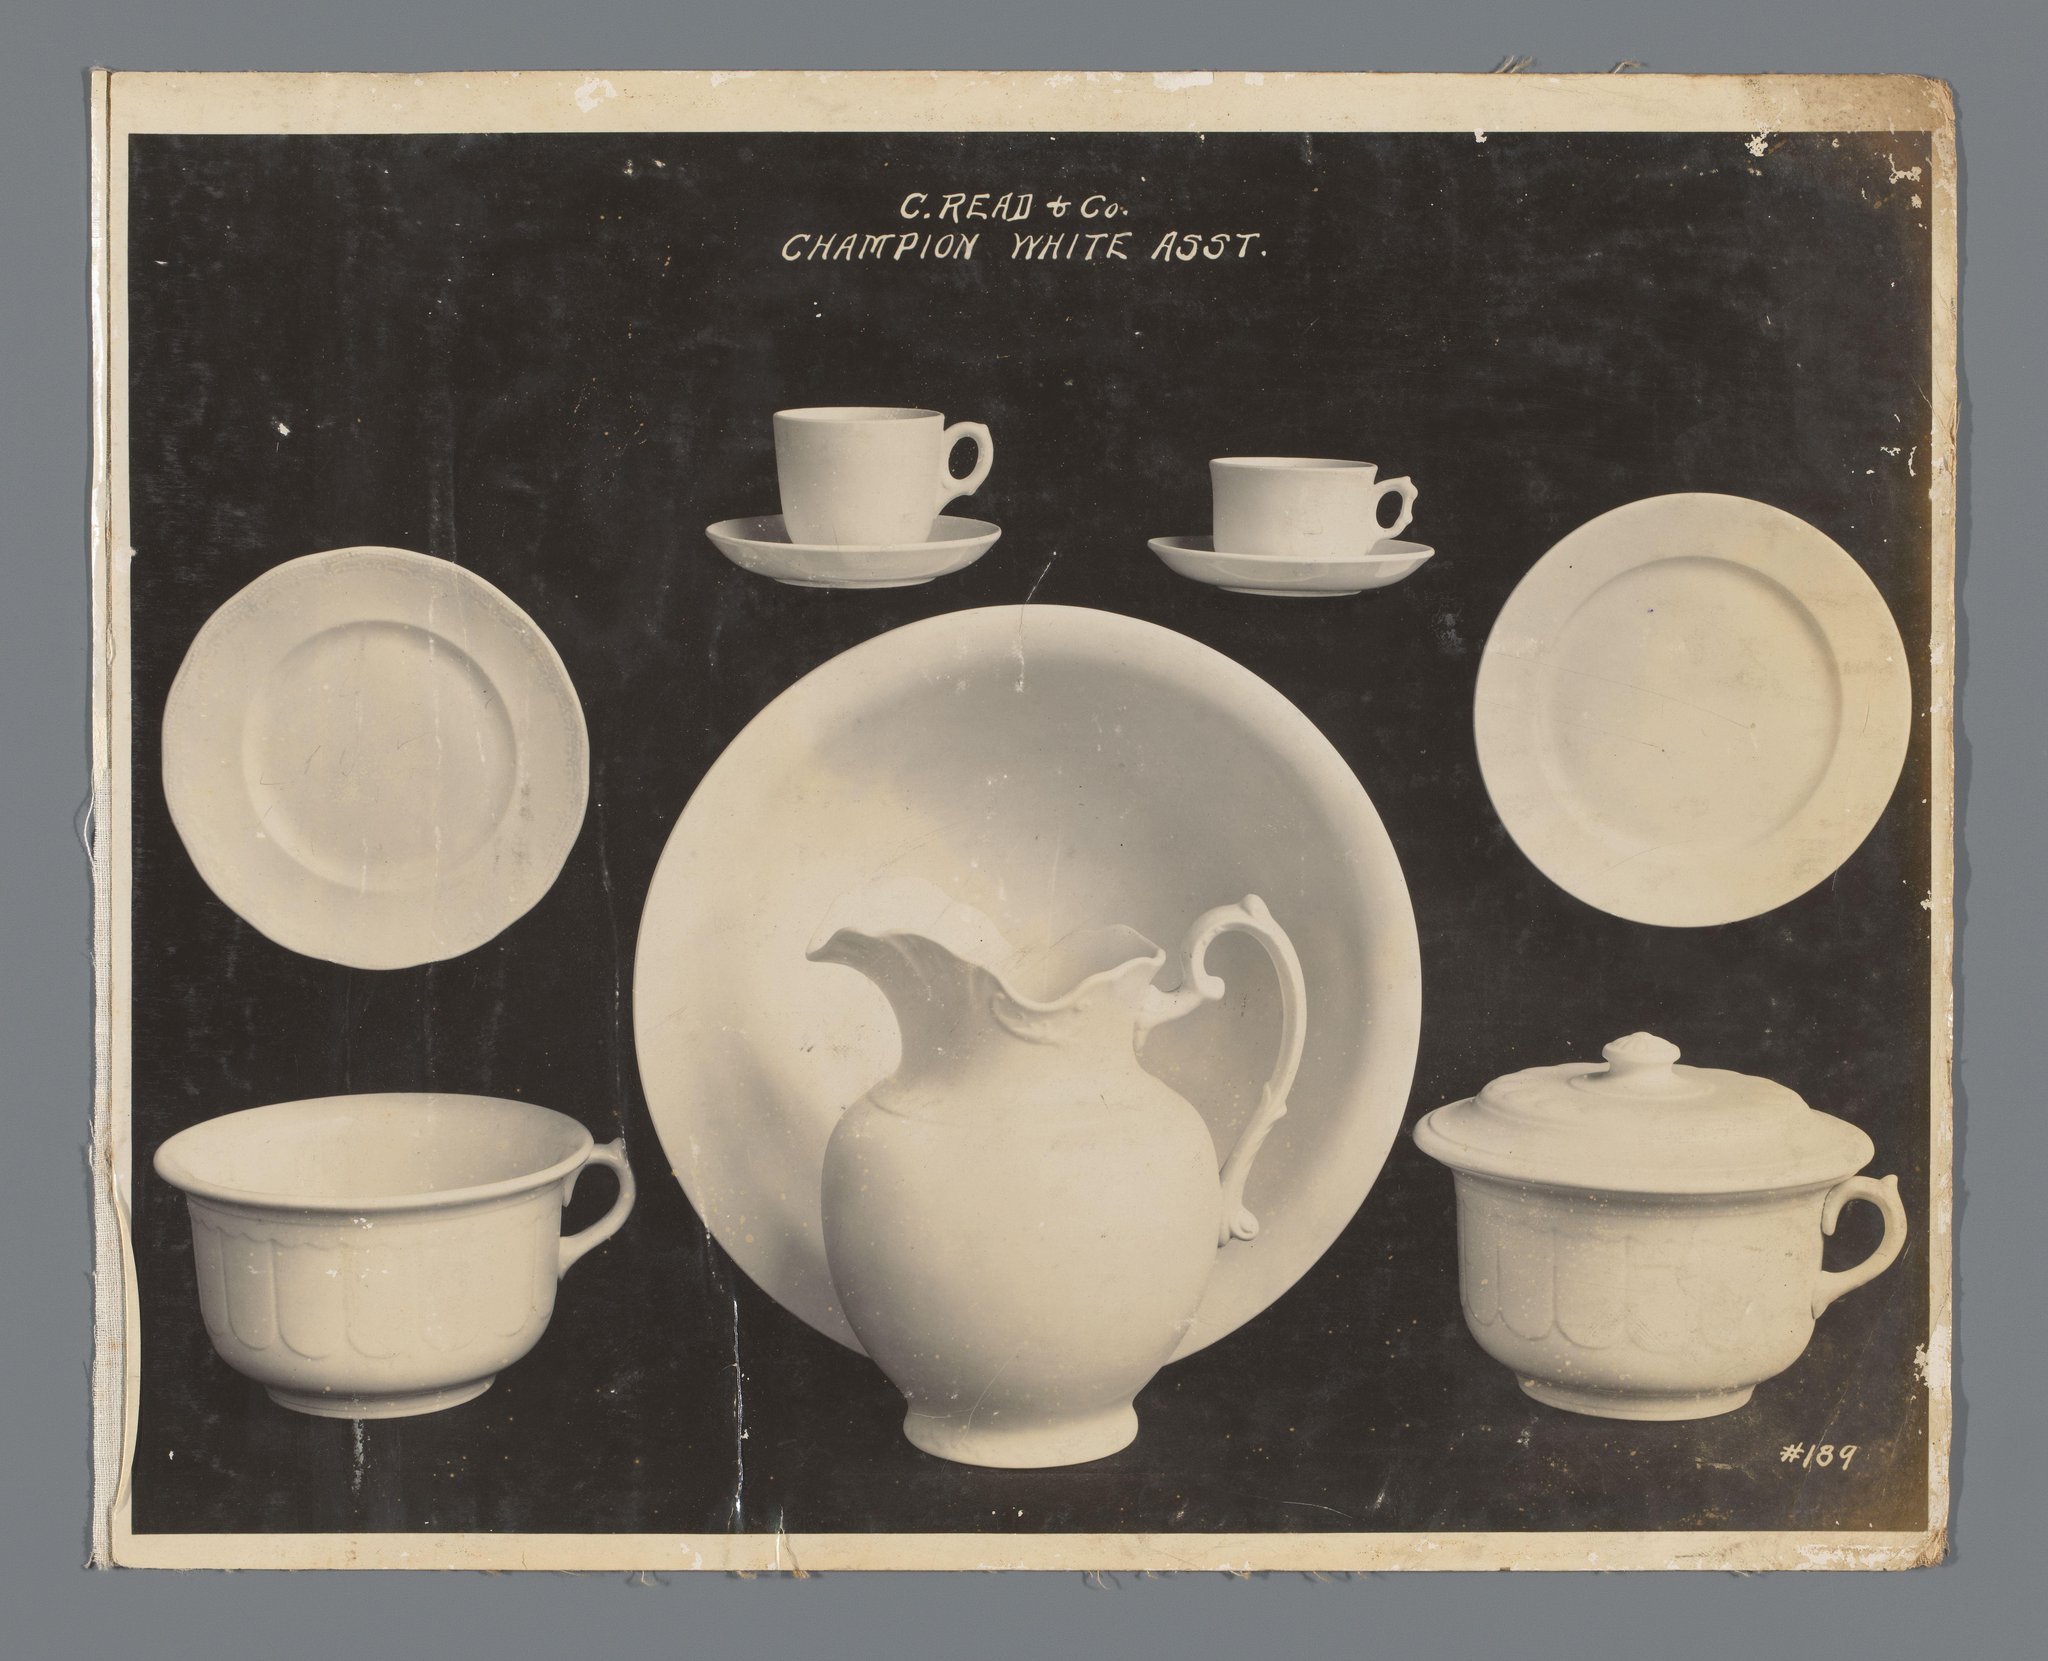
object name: photograph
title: Reclamefoto met serviezen en keukengerei van de firma C. Read & Co., Baltimore, Maryland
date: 1920-1930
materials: paper, textile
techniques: photography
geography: united states